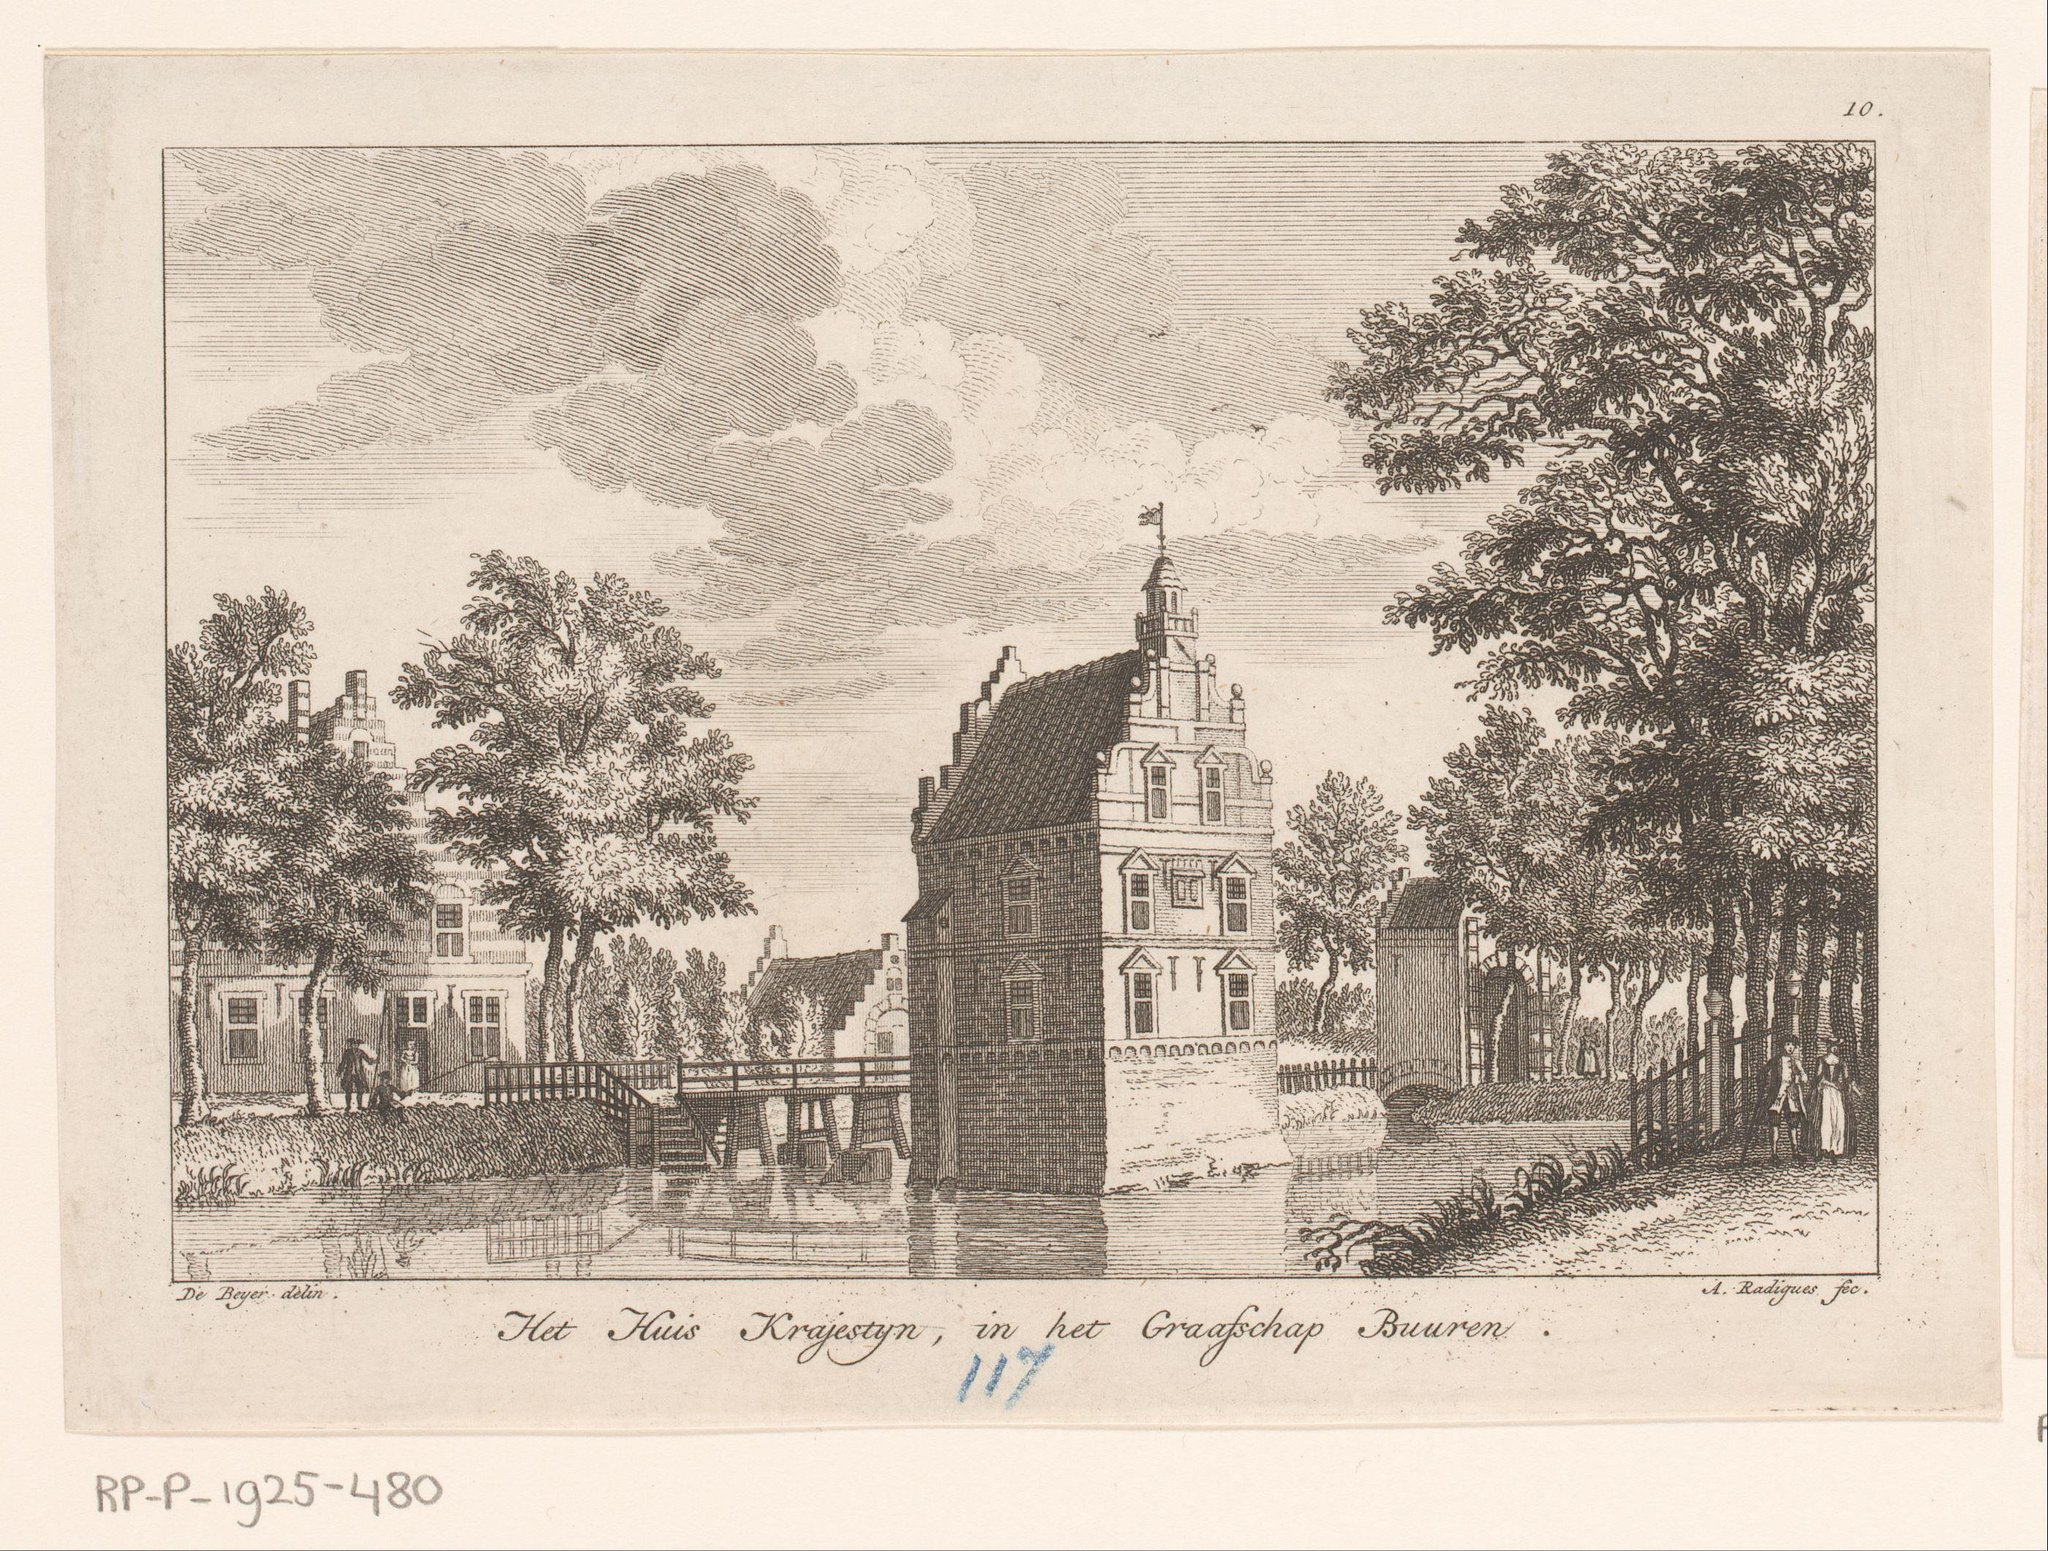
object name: print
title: Het Huis Krajestijn, in het Graafschap Buuren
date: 1750-1760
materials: paper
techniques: etching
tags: landscape with tower or castle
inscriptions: collector's mark: Lugt 2228